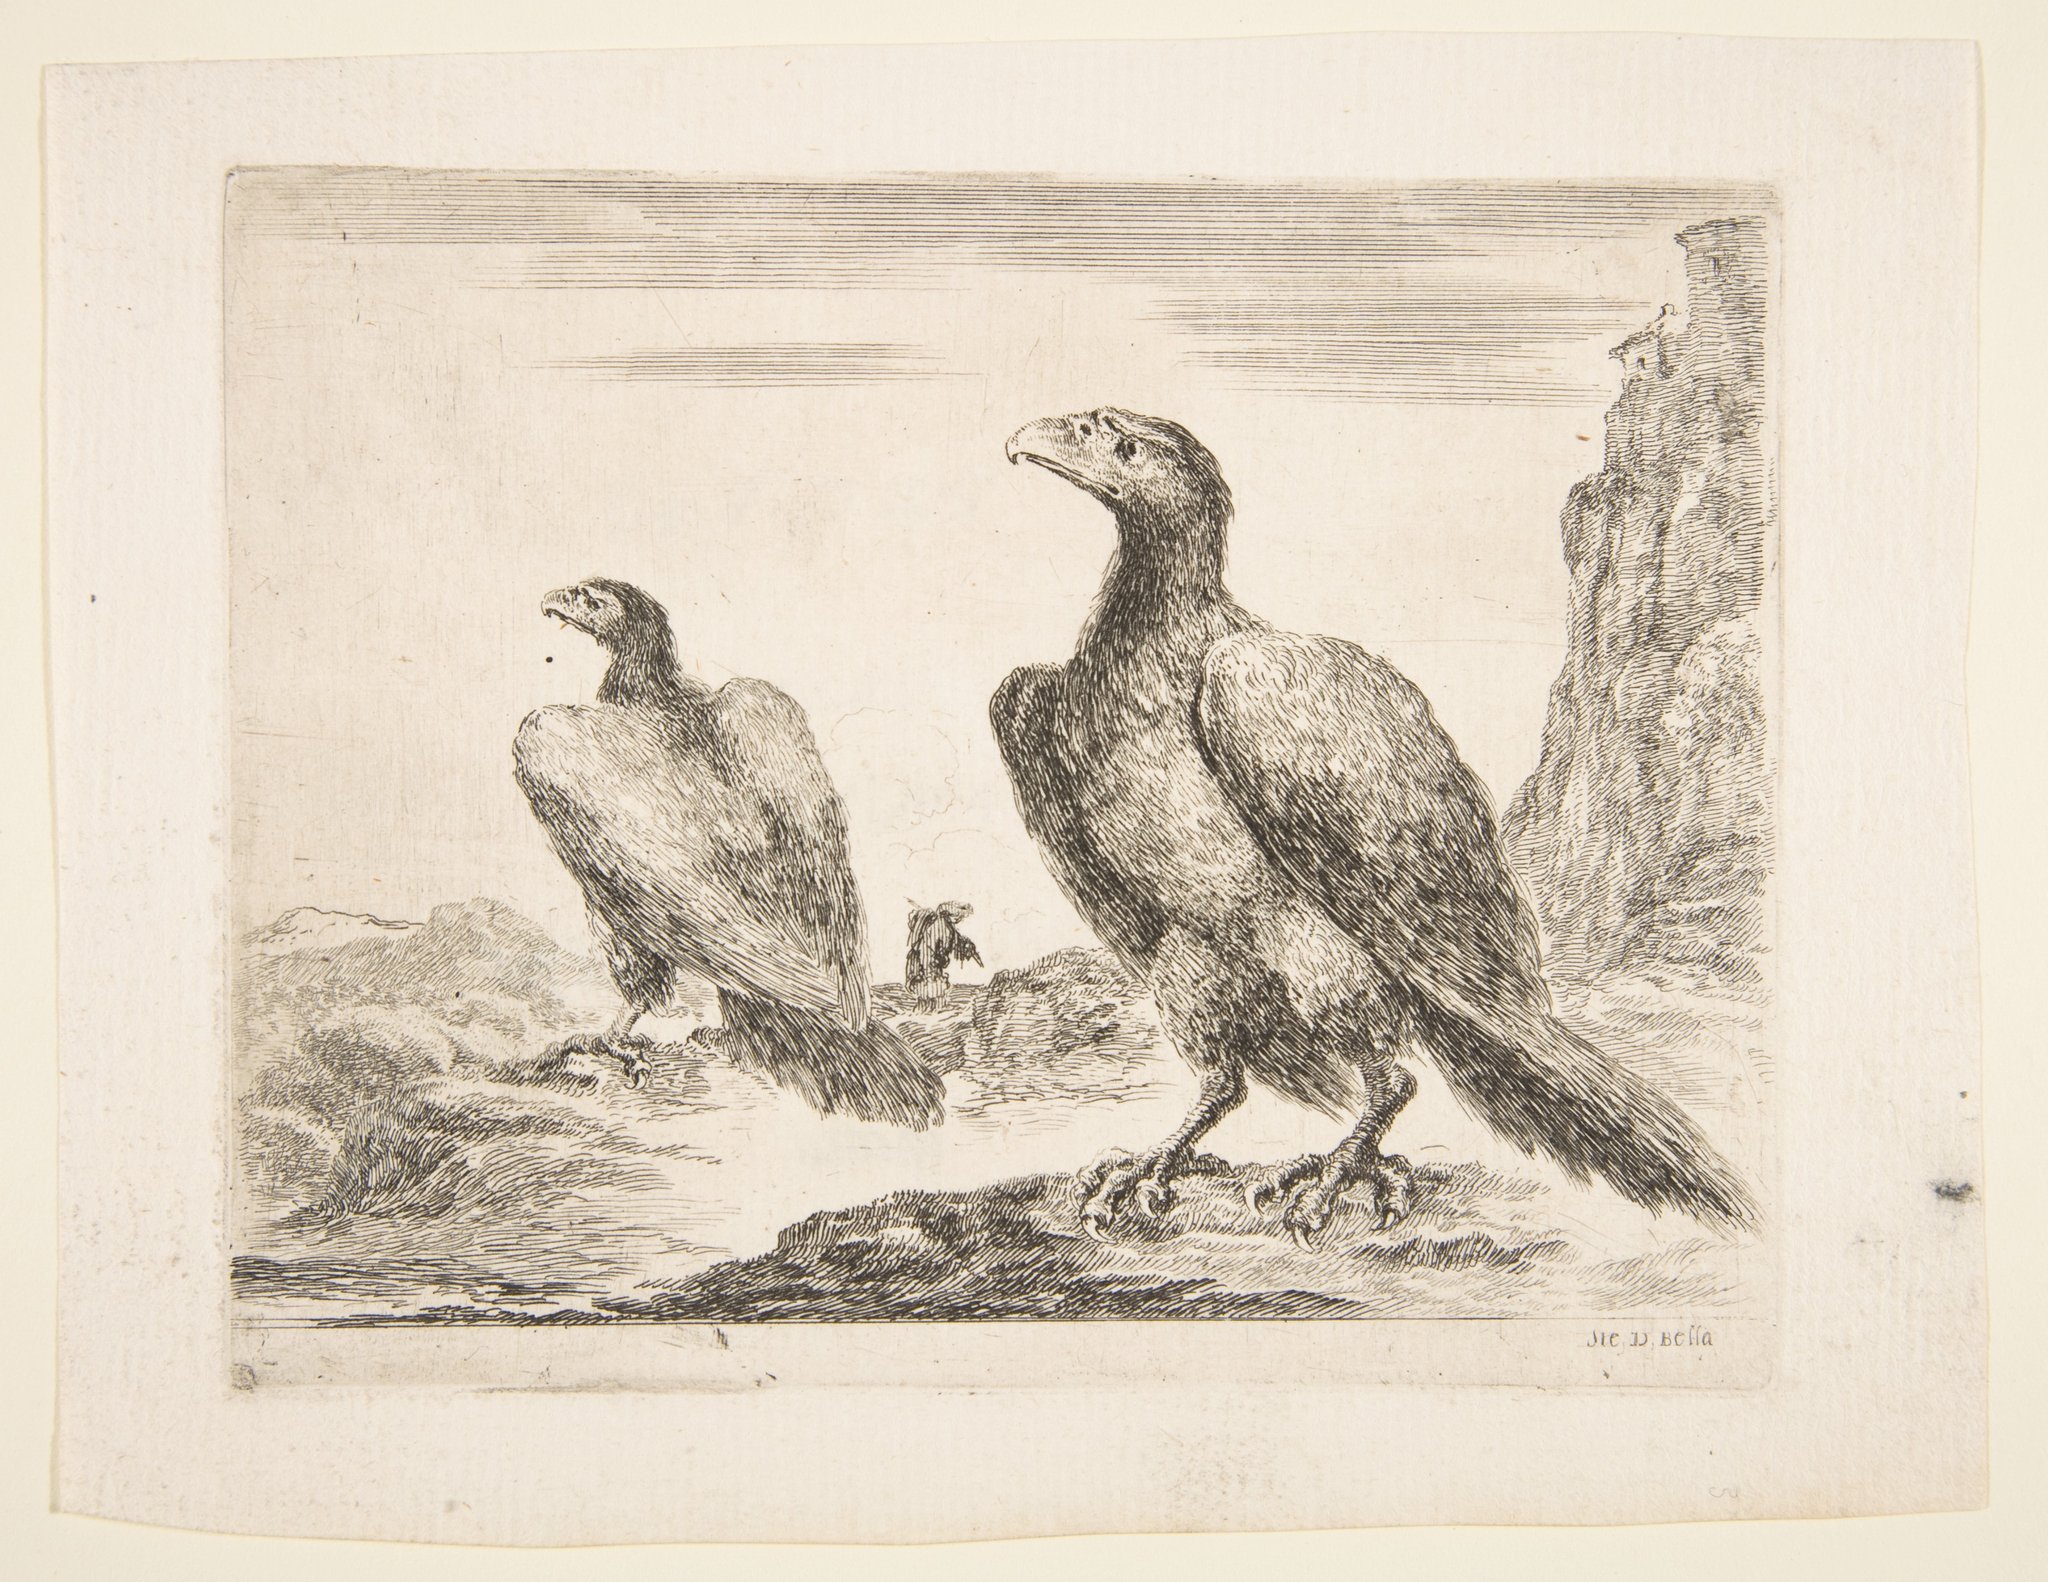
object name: print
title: Two eagles, from 'Eagles' (Les aigles)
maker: stefano della bella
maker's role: artist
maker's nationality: italian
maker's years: 1610-1664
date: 1651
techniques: etching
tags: eagles